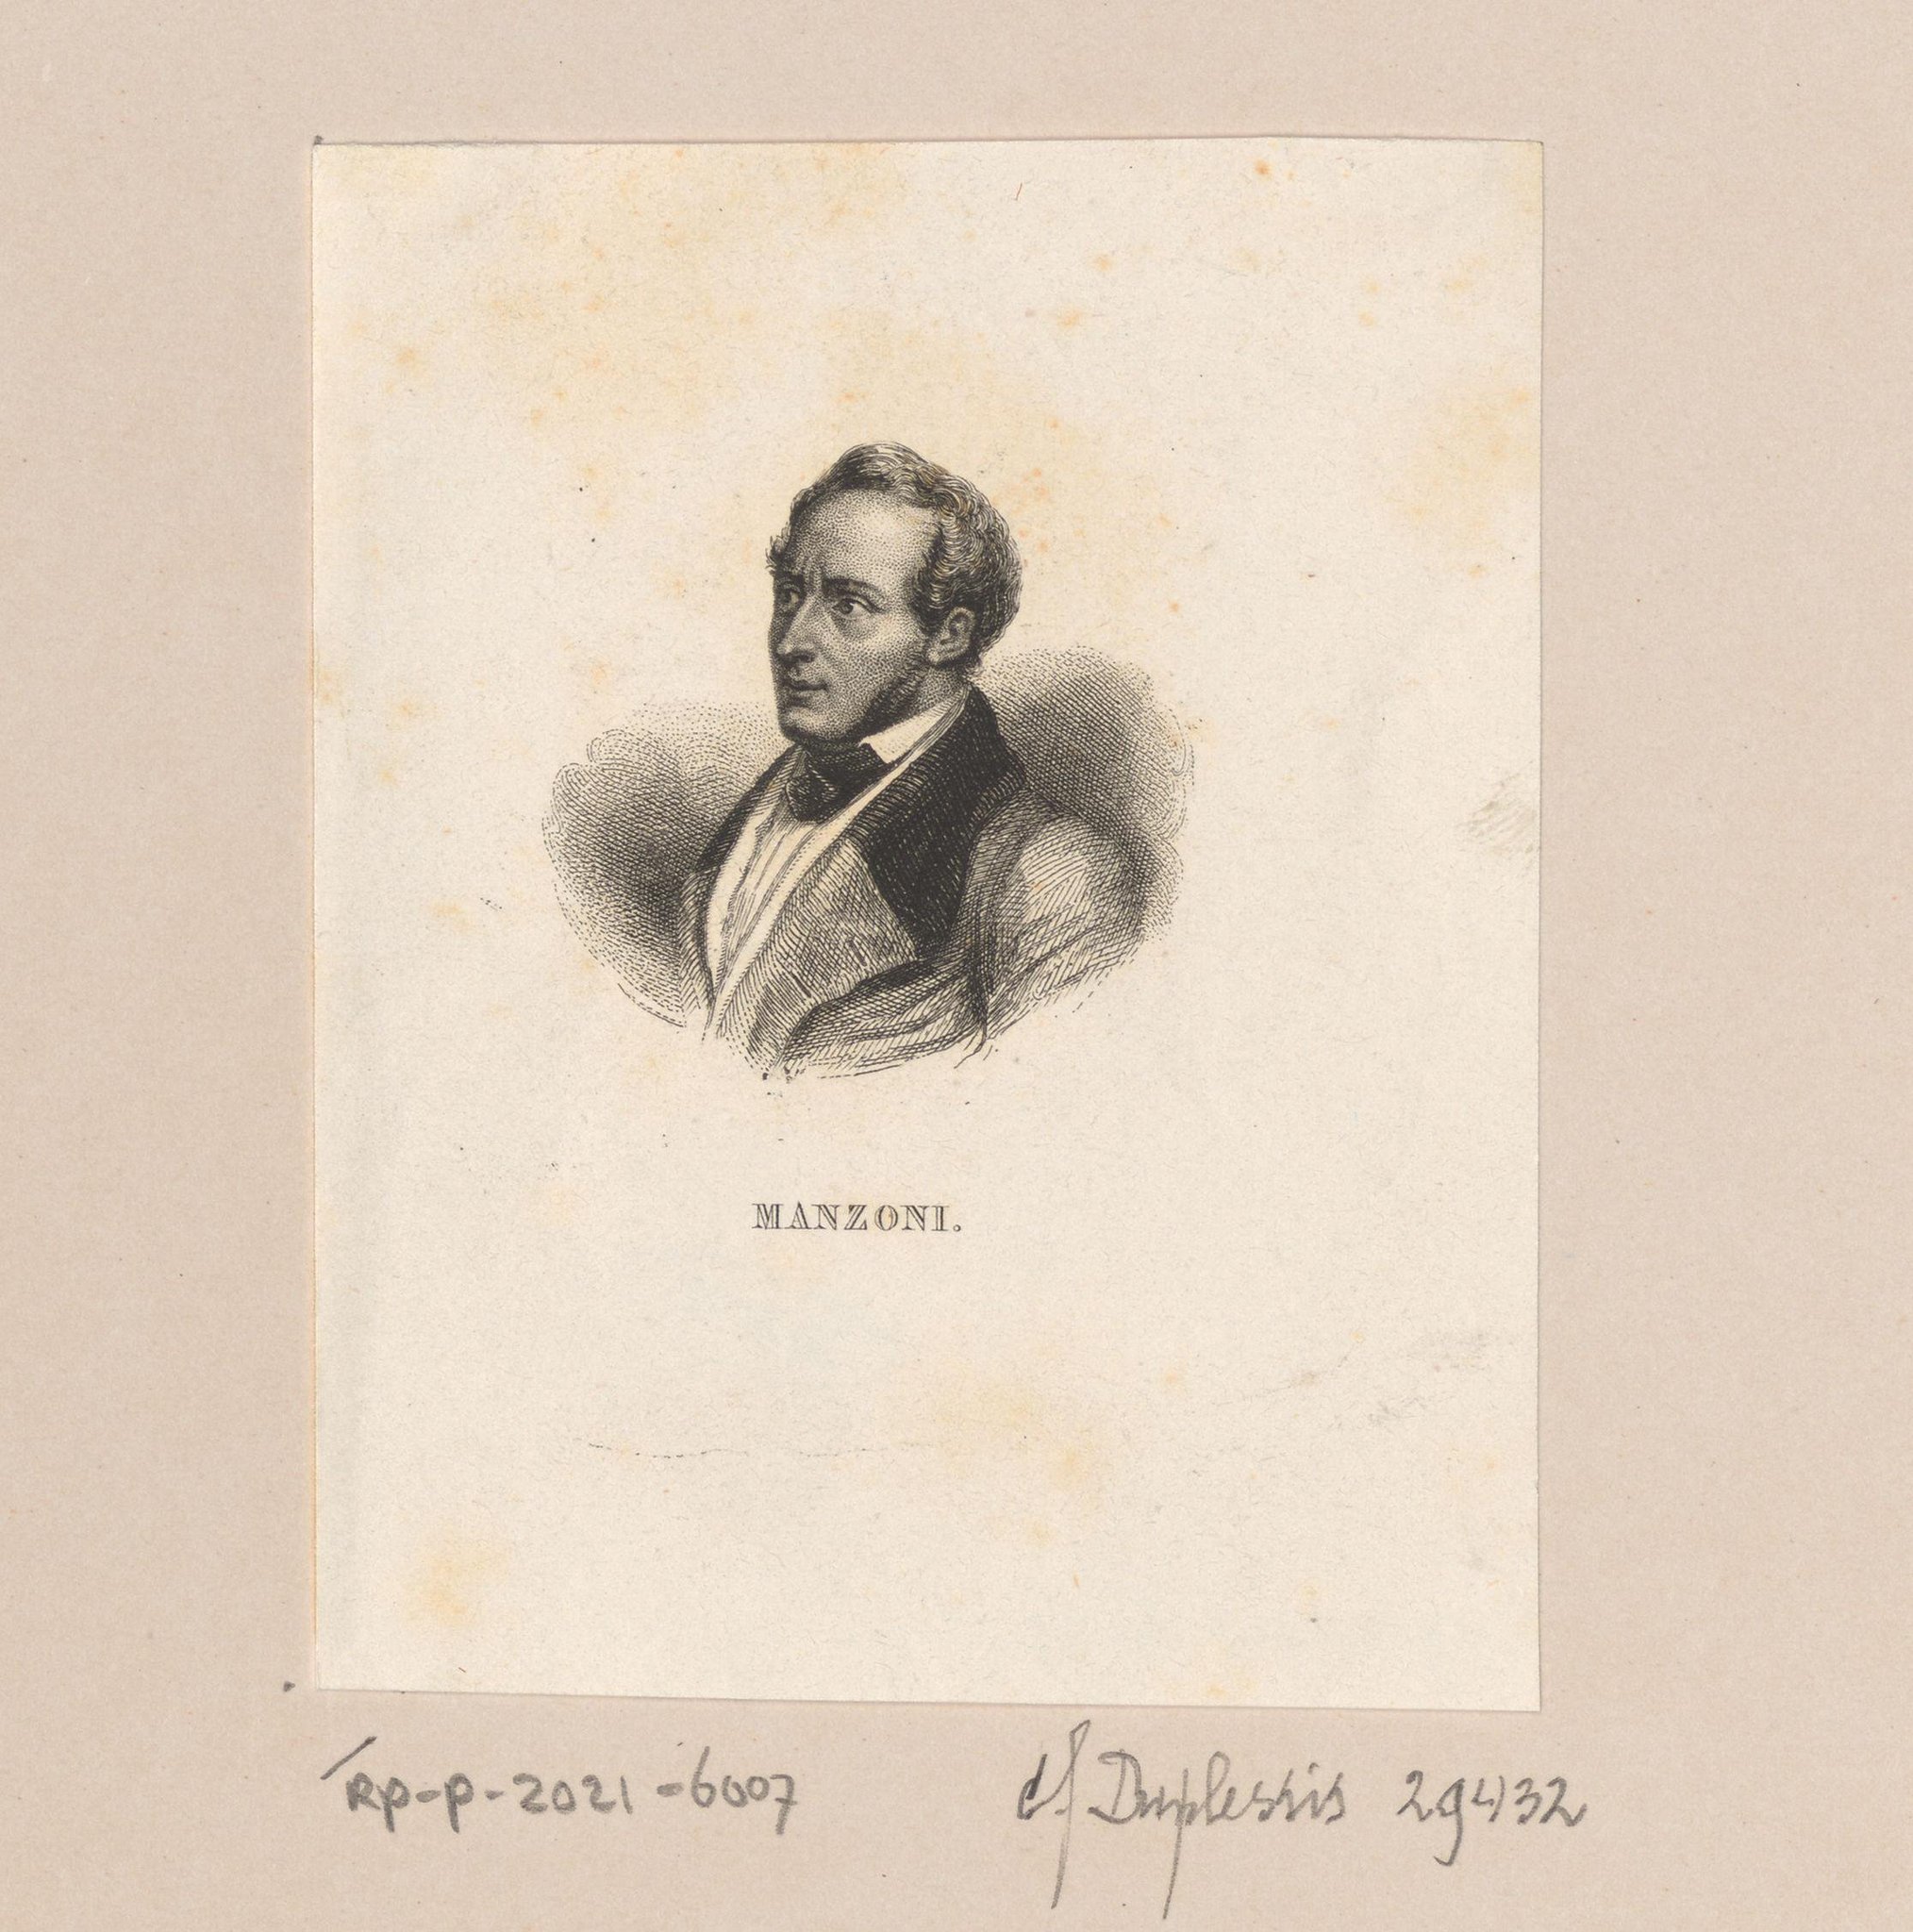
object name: print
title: Portret van Alessandro Manzoni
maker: Anonymous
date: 1820-1899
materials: paper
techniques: engraving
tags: historical persons, portrait of a writer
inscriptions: collector's mark: Lugt 2228